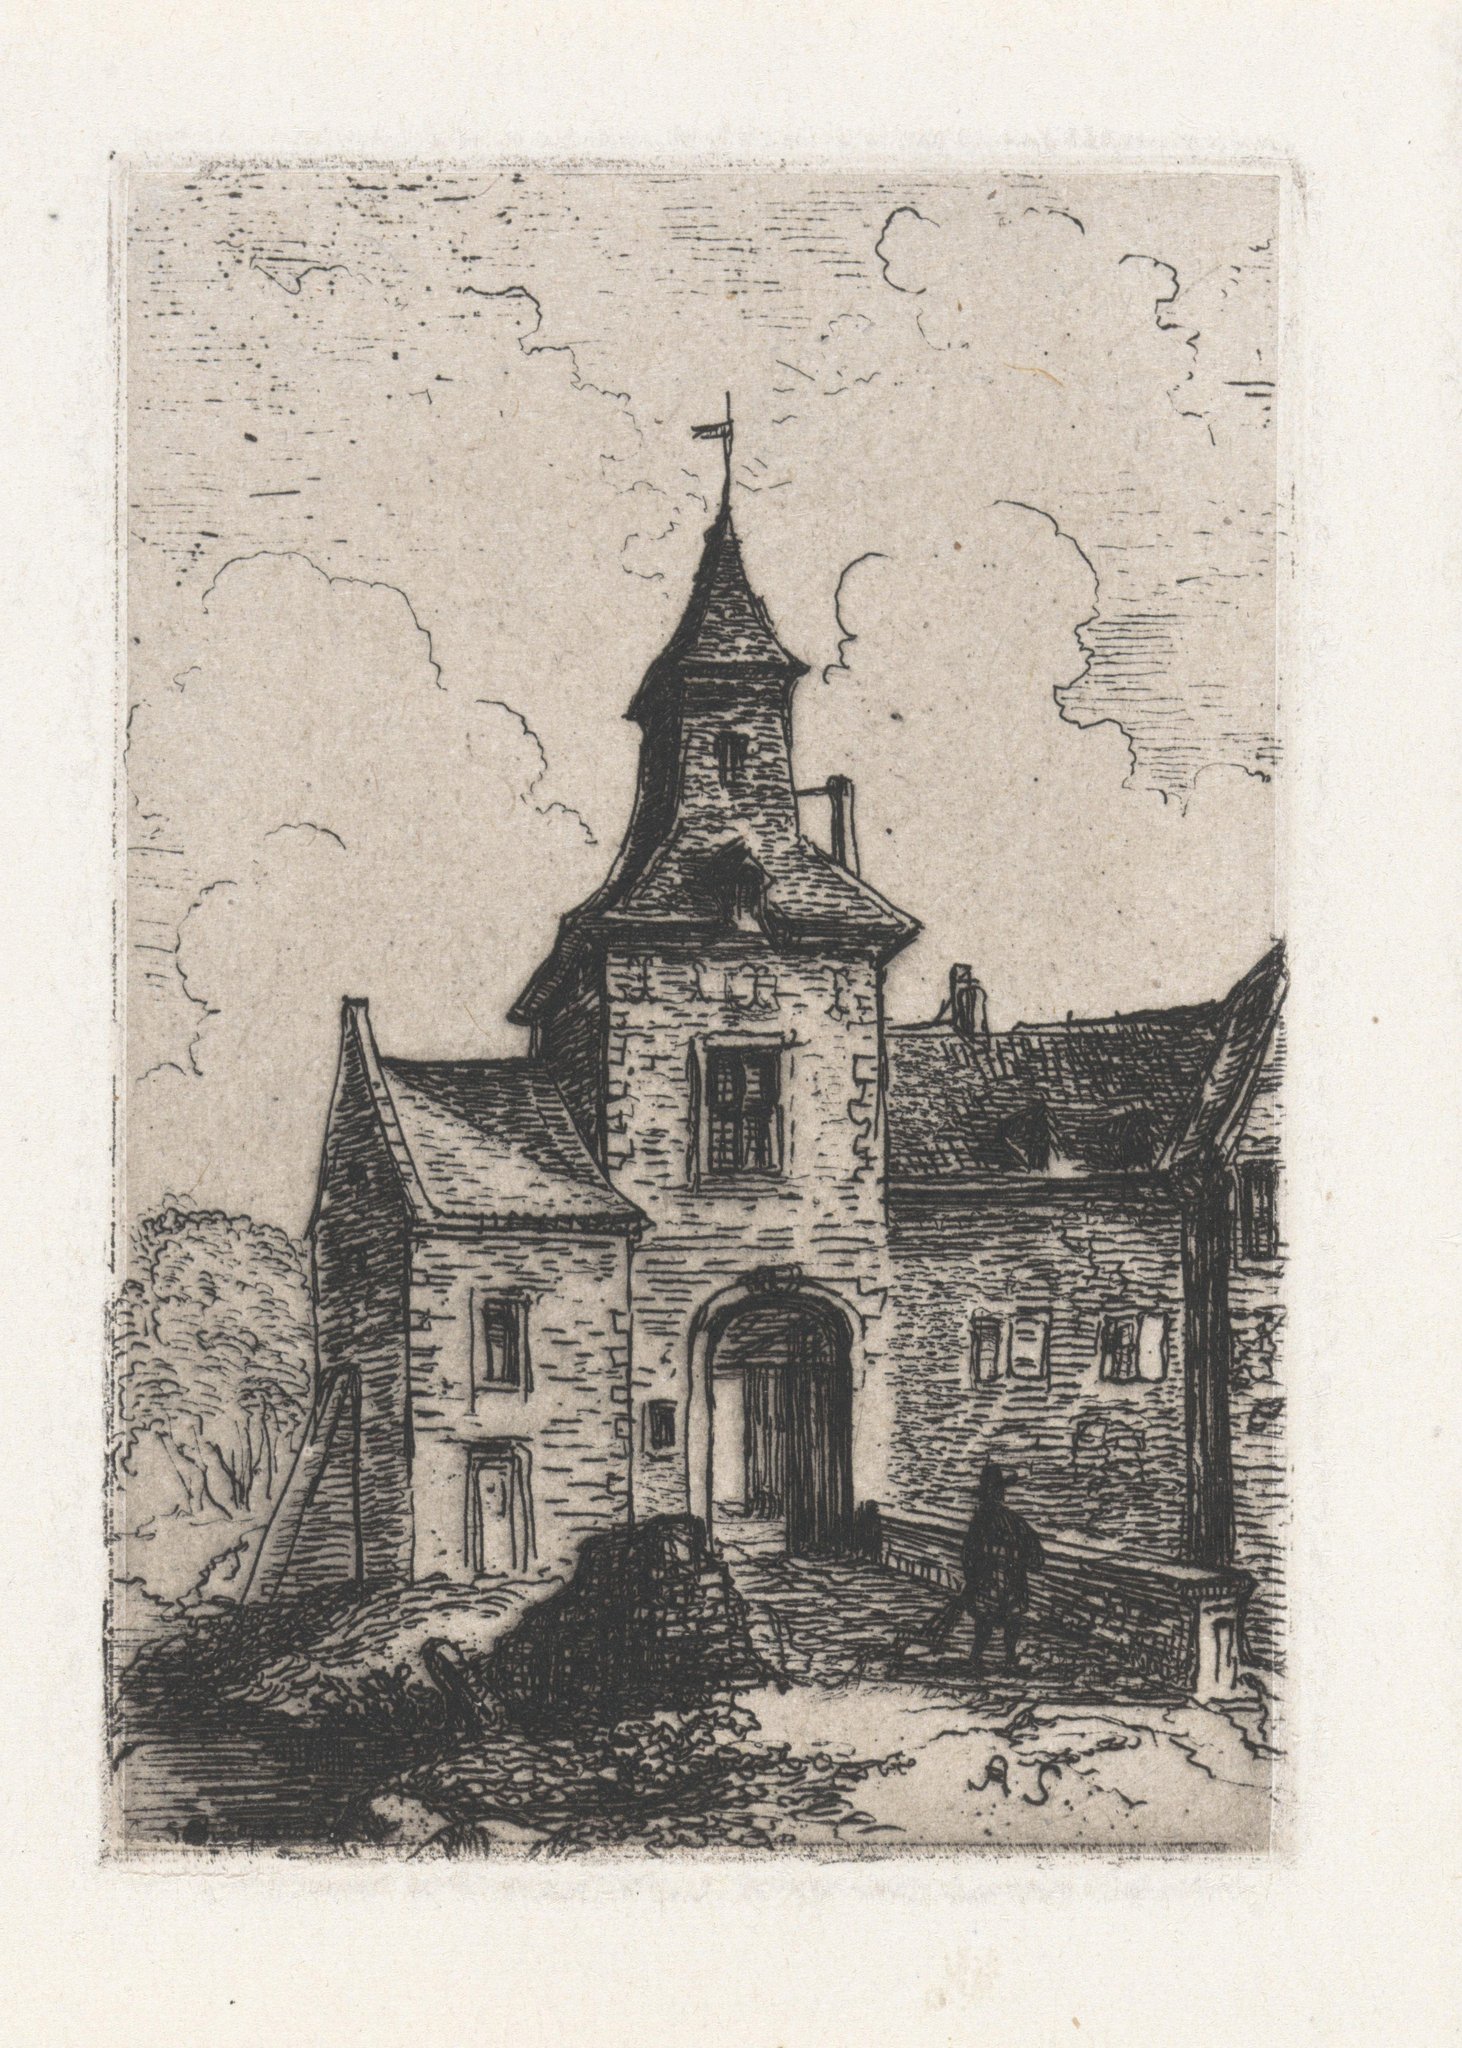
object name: print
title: Toegangspoort naar een kasteel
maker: alexander schaepkens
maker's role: draughtsman, print maker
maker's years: 1815-1899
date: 1830-1899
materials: paper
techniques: etching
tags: castle, gate, entrance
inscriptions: collector's mark: Lugt 2228